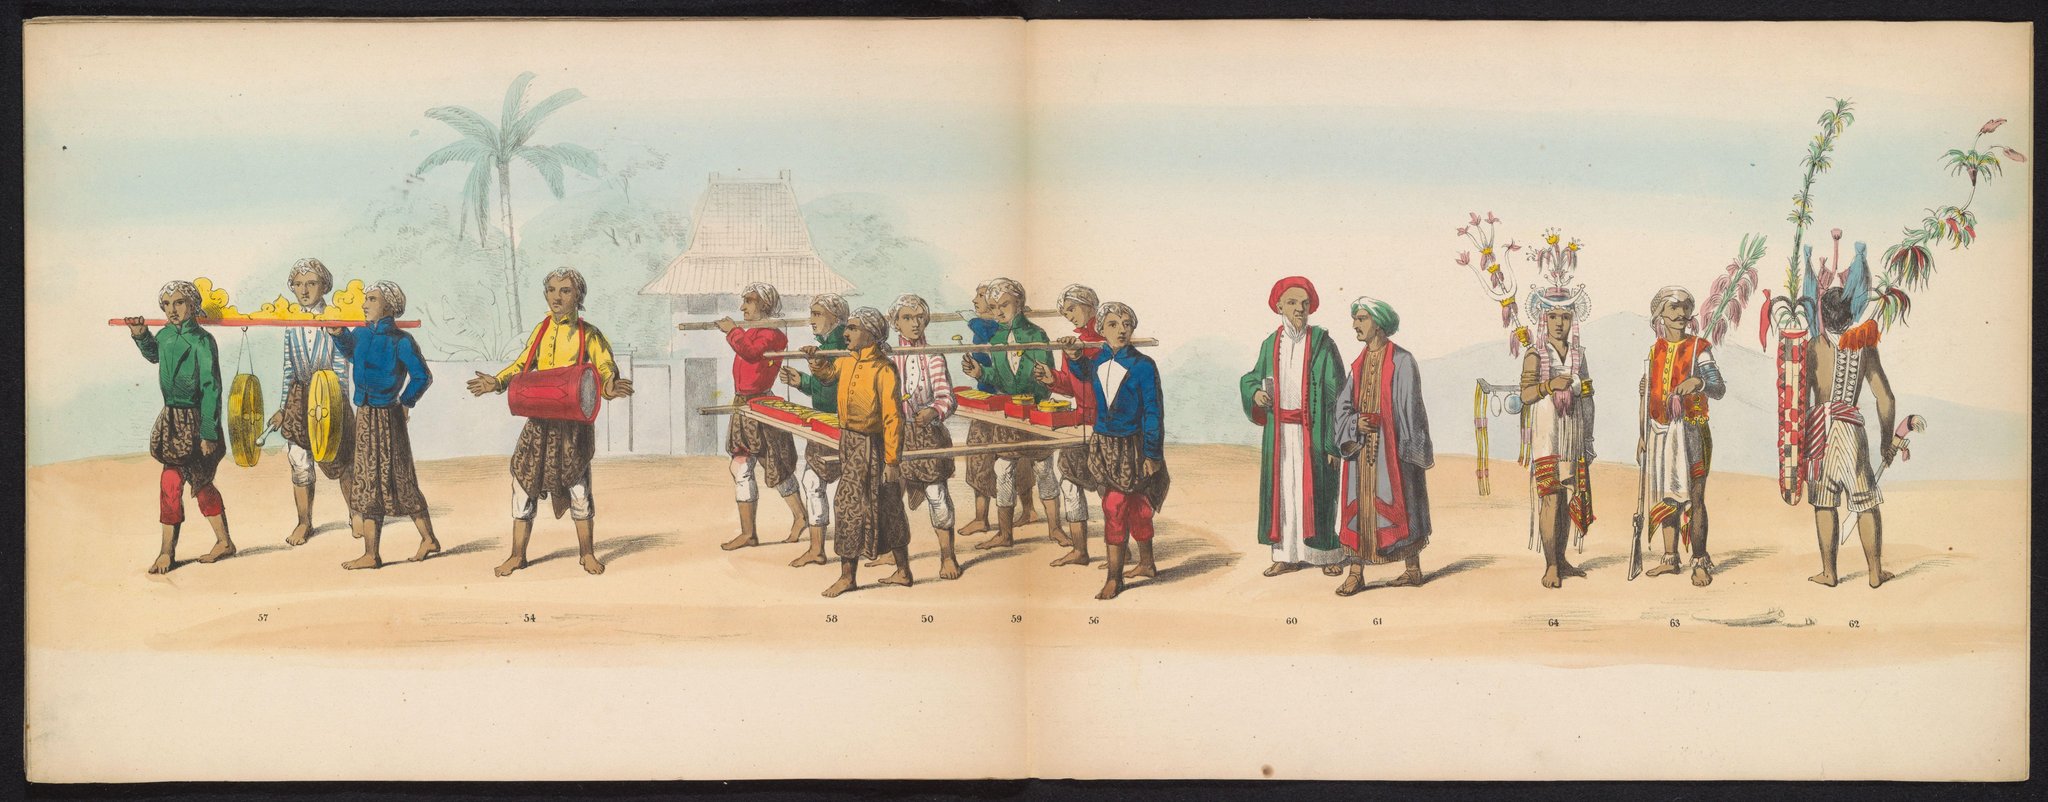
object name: print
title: Maskerade van de Delftse studenten, 1857 (plaat 7)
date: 1857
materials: paper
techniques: hand coloring, lithograph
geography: netherlands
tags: students' pageant, costumes used in pageants, delft, dutch east indies, the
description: Gekostumeerde optocht van de studenten van de Koninklijke Akademie te Delft op 5 mei 1857. De optocht verbeeldt de Garebeg optocht van de sultan van Djokjakarta plus verschillende karakteristieke types uit de Indonesische archipel. Zevende plaat met de groepen genummerd 54-64. Onderdeel van de serie van acht en een half aanelkaar geplakte bladen.